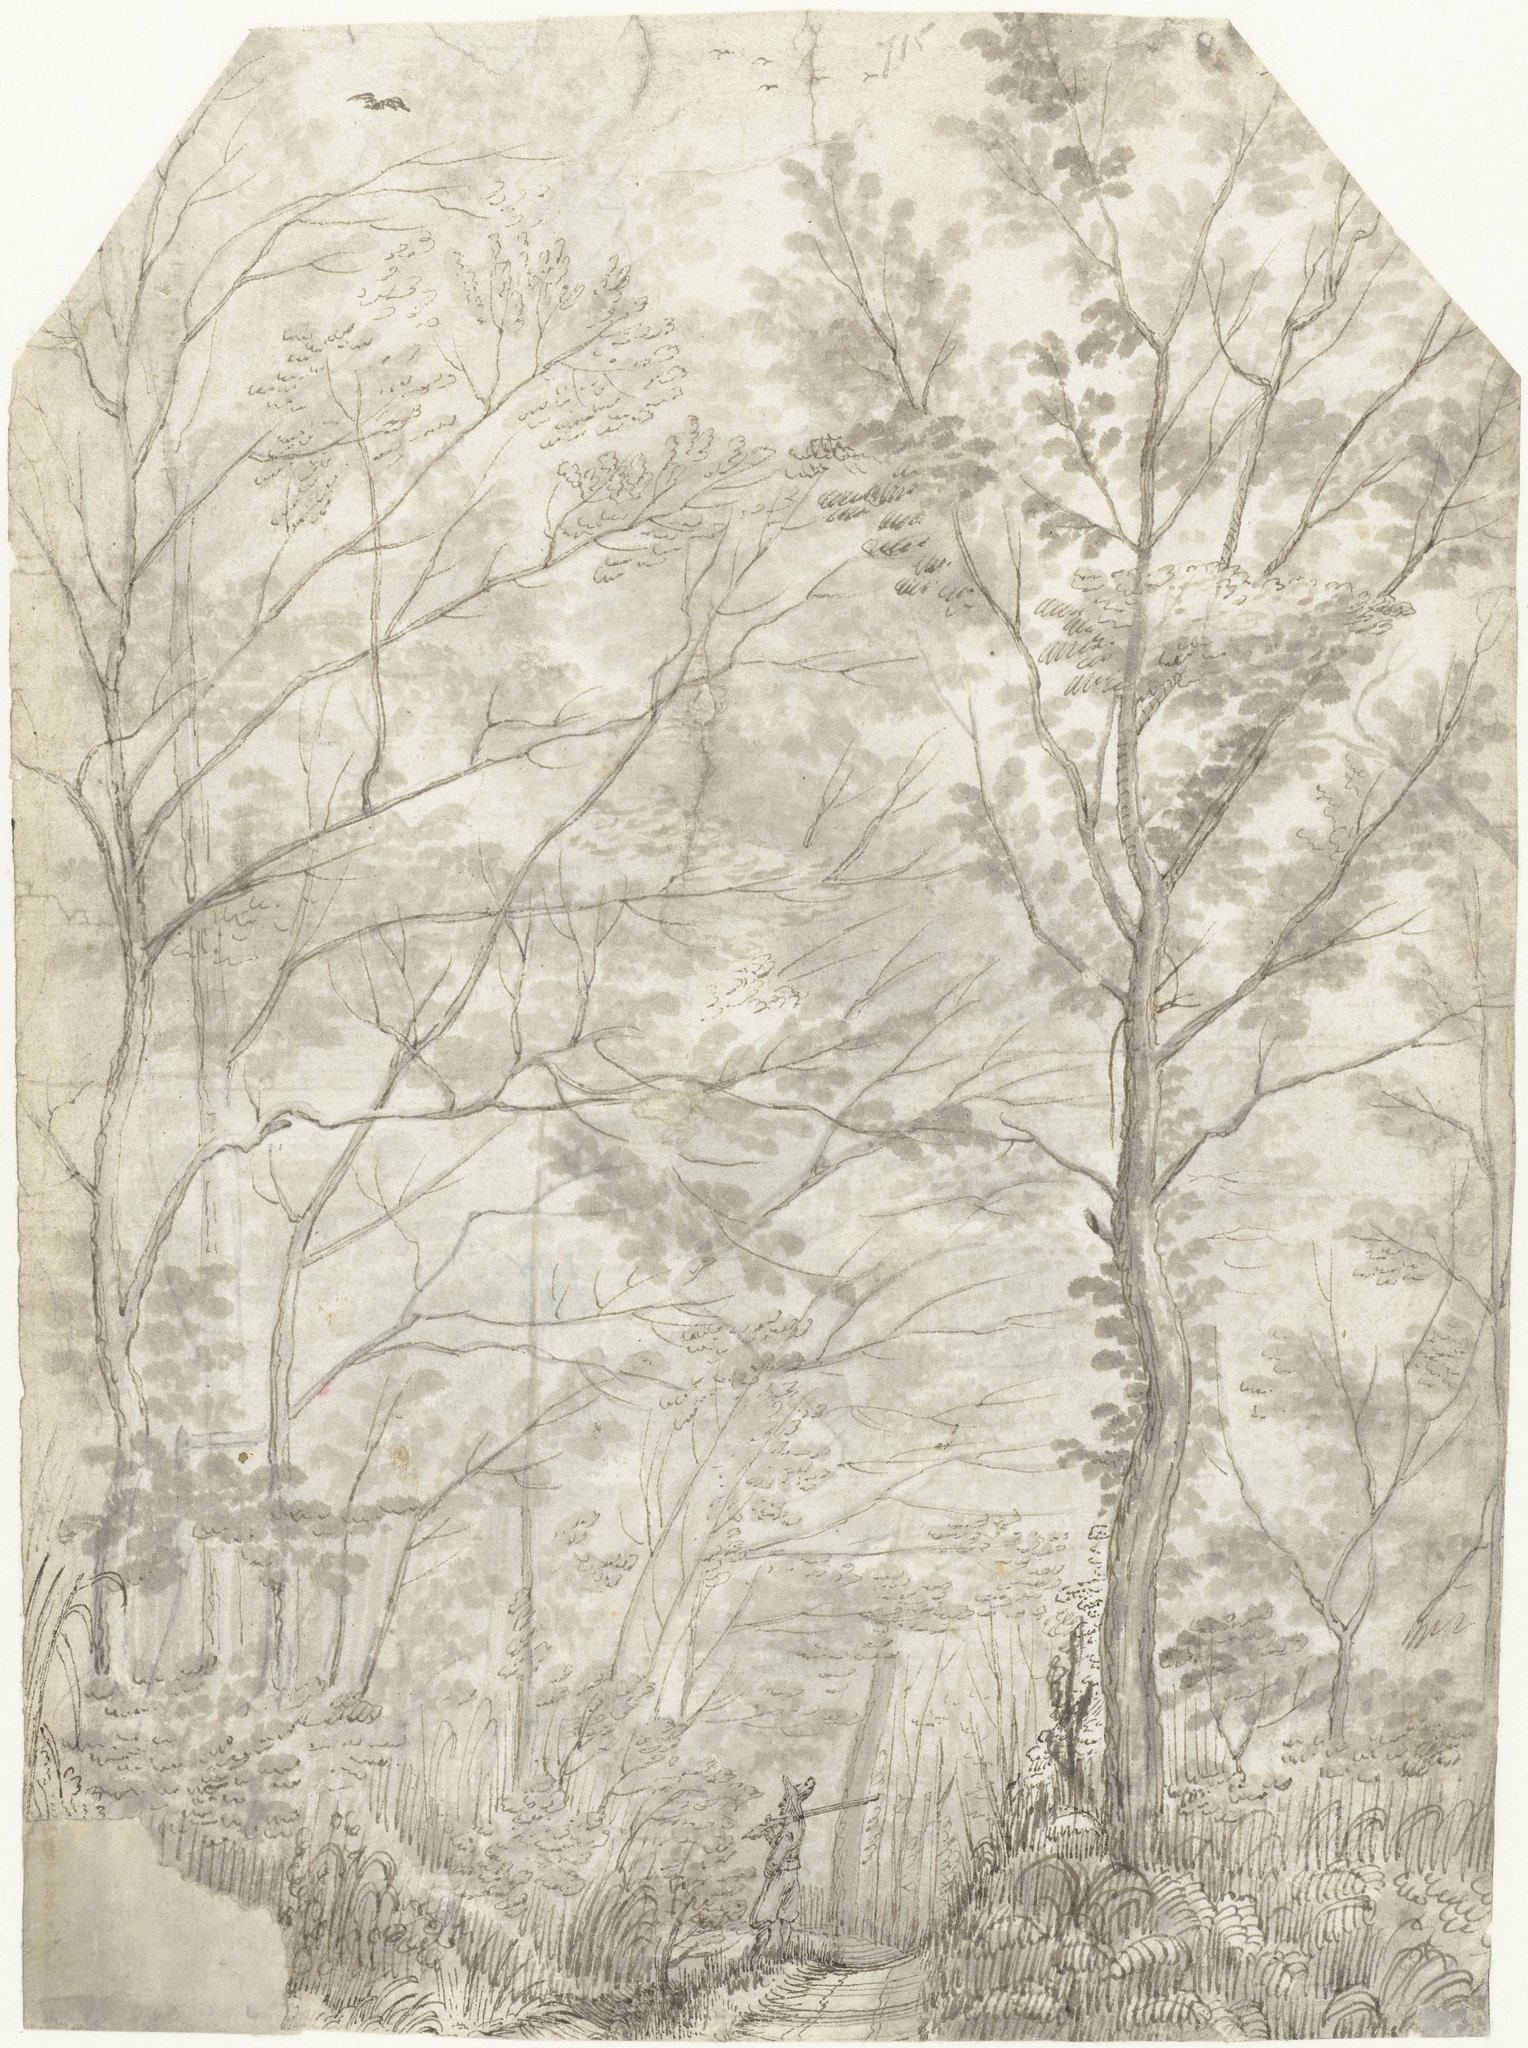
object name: drawing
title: Bos van de Villa Madama buiten Rome, met een jager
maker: gerard ter borch (i)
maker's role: draughtsman, print maker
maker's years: 1584-1662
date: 1610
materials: chalk, ink, paper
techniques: brush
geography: rome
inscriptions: annotation: ‘in vinia maddamma’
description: Tekening uit het Romeinse schetsboek van de kunstenaar.